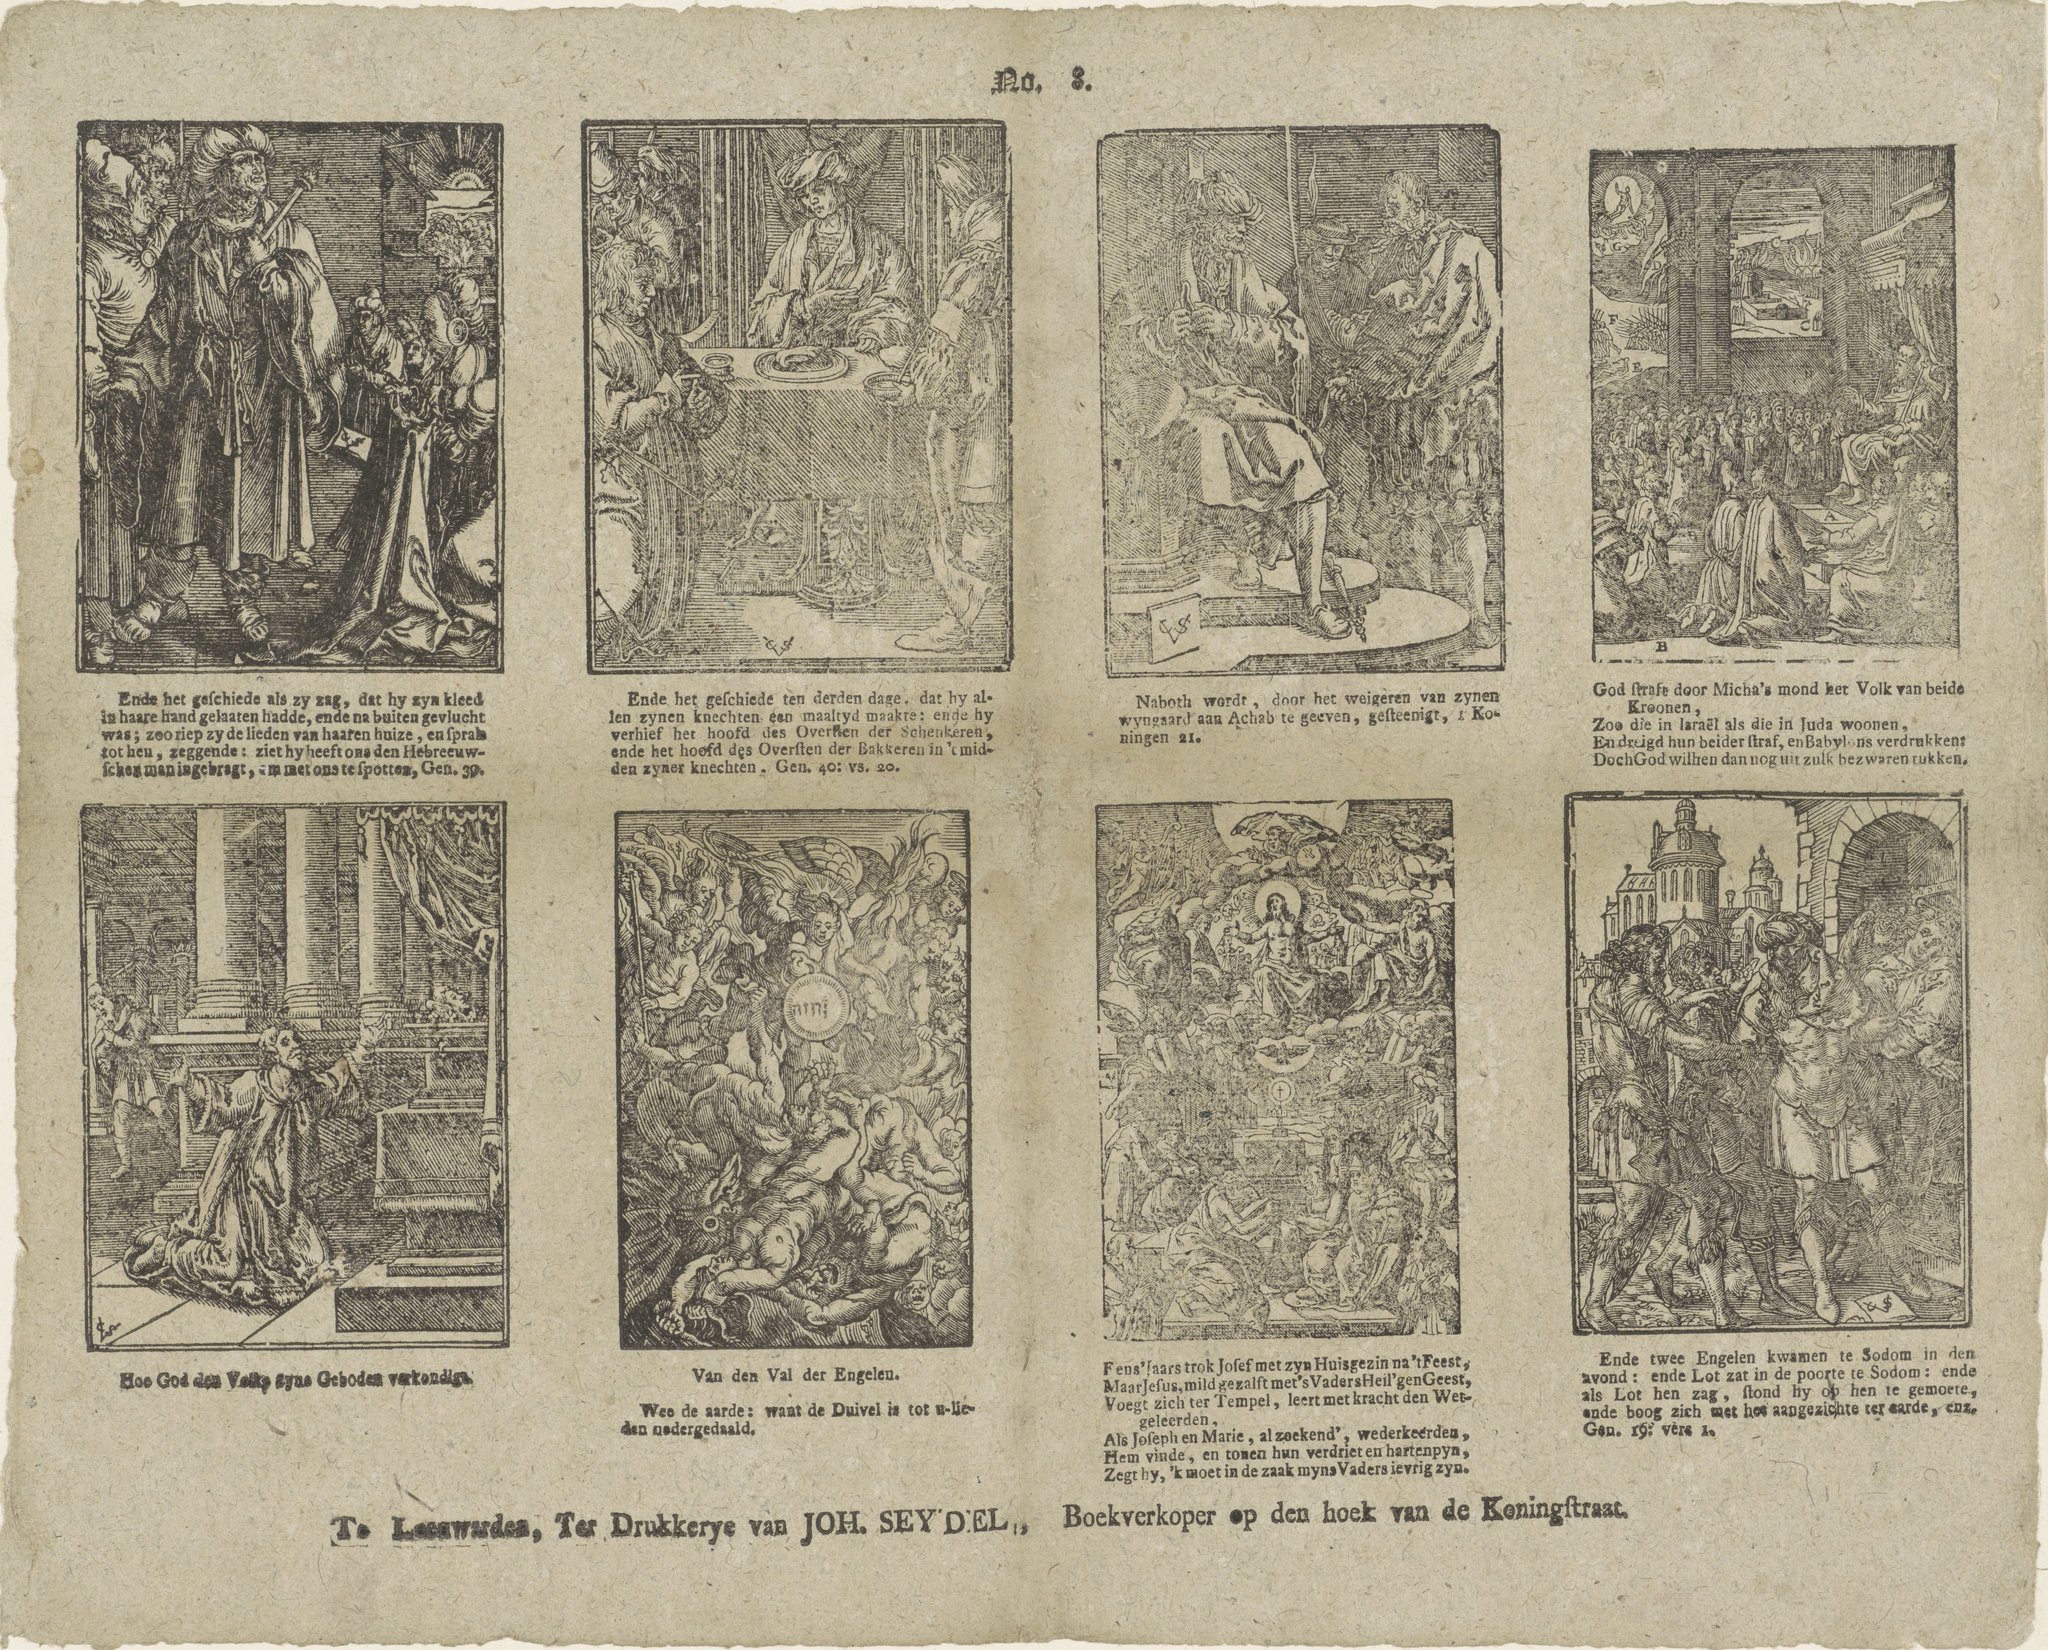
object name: print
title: Taferelen uit het Oude Testament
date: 1776-1813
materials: paper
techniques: letterpress printing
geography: leeuwarden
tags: genesis: the story of joseph, old testament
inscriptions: collector's mark: Lugt 2760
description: De afbeeldingen links boven zijn vrije kopieën naar prenten van Lucas van Leyden (Zie New Hollstein nrs. 21 en 23). De tweede afbeelding van linksonder is naar het schilderij 'Michaël en de val van de opstandige engelen' door Rubens (voor prent naar schilderij zie RP-P-OB-70.344).